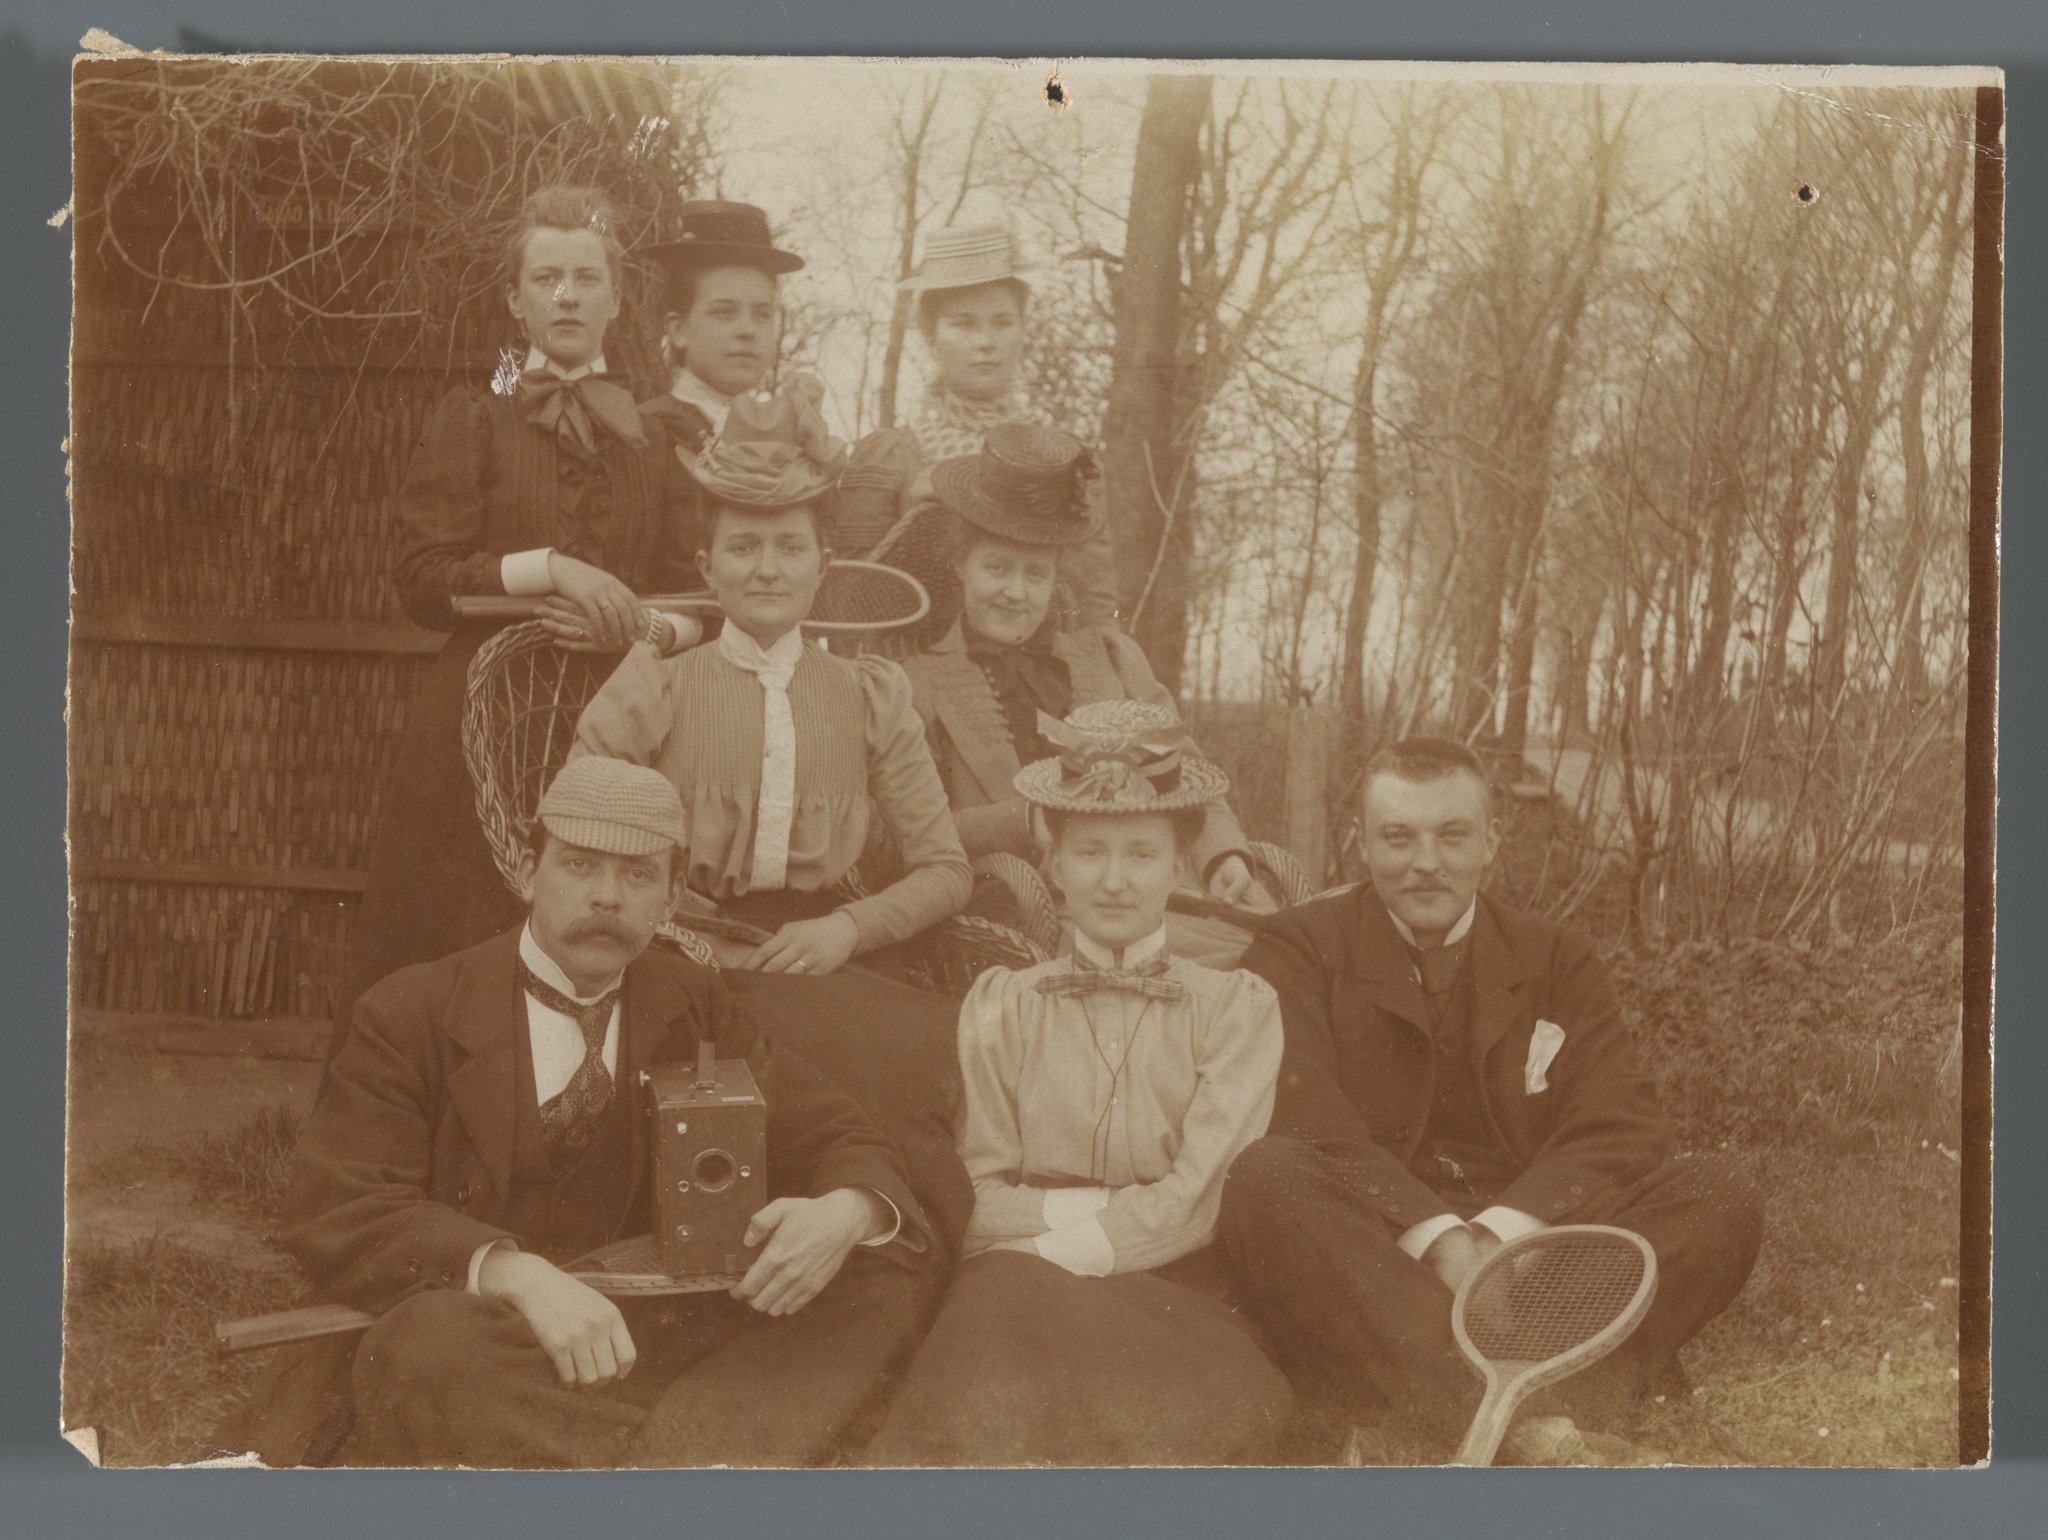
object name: photograph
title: Portret van een groep onbekende mensen, waarvan een met camera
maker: Anonymous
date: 1880-1940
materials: photographic support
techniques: collodion silver print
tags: camera ~ photography, anonymous historical persons portrayed in a group, in a group-portrait